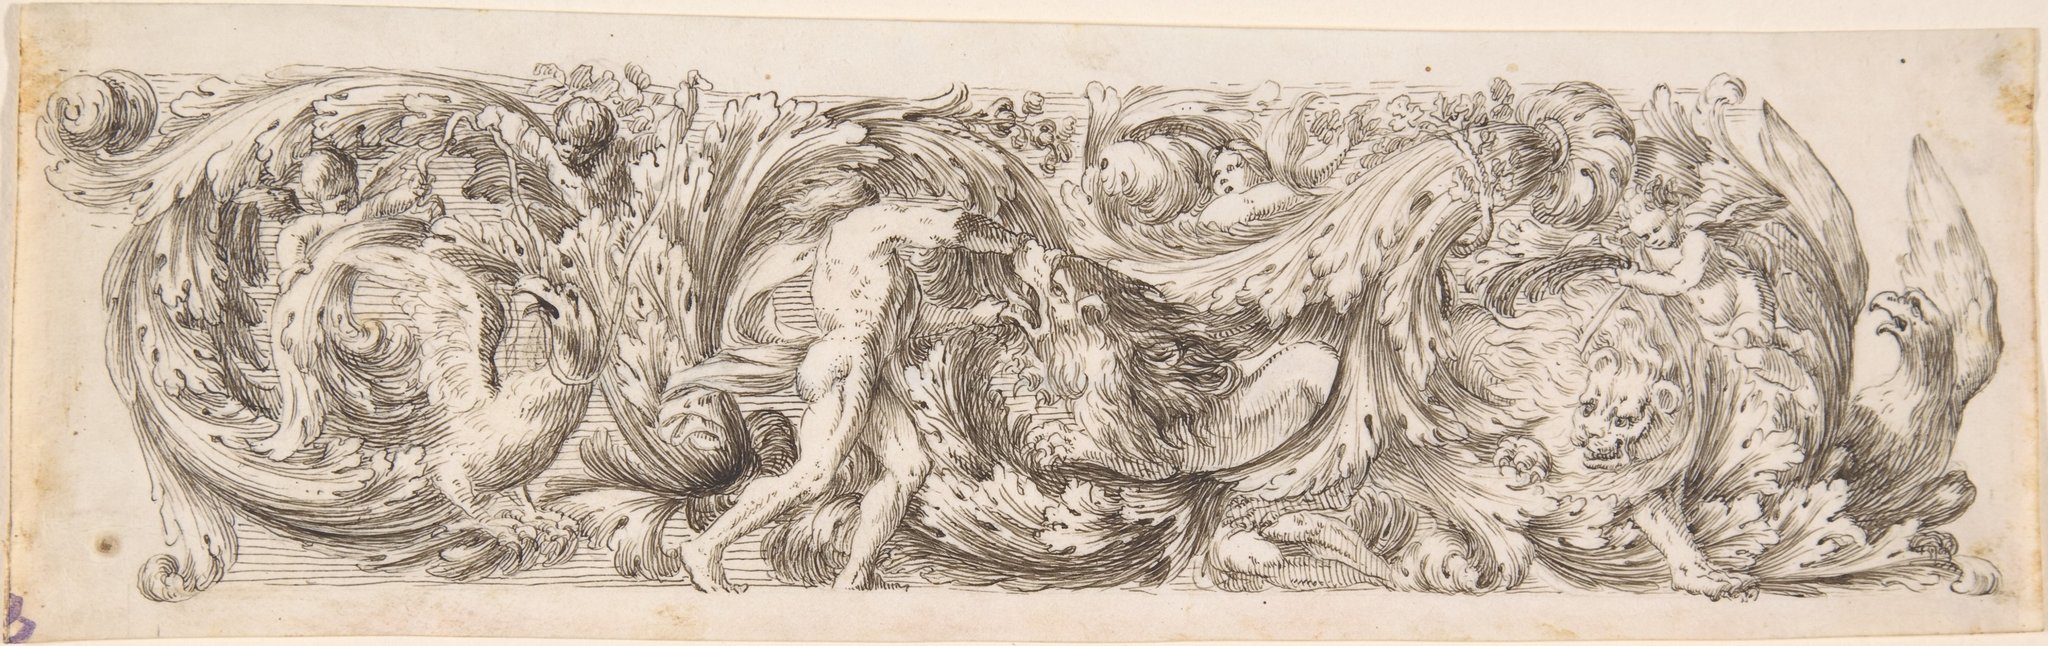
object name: drawing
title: Frieze with Acanthus Scrolls and a Man (Hercules?) fighting a Lion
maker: jean le pautre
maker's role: artist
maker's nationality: french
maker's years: 1618-1682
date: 1601-1700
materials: chalk, ink, parchment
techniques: pen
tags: men,lions,acanthus